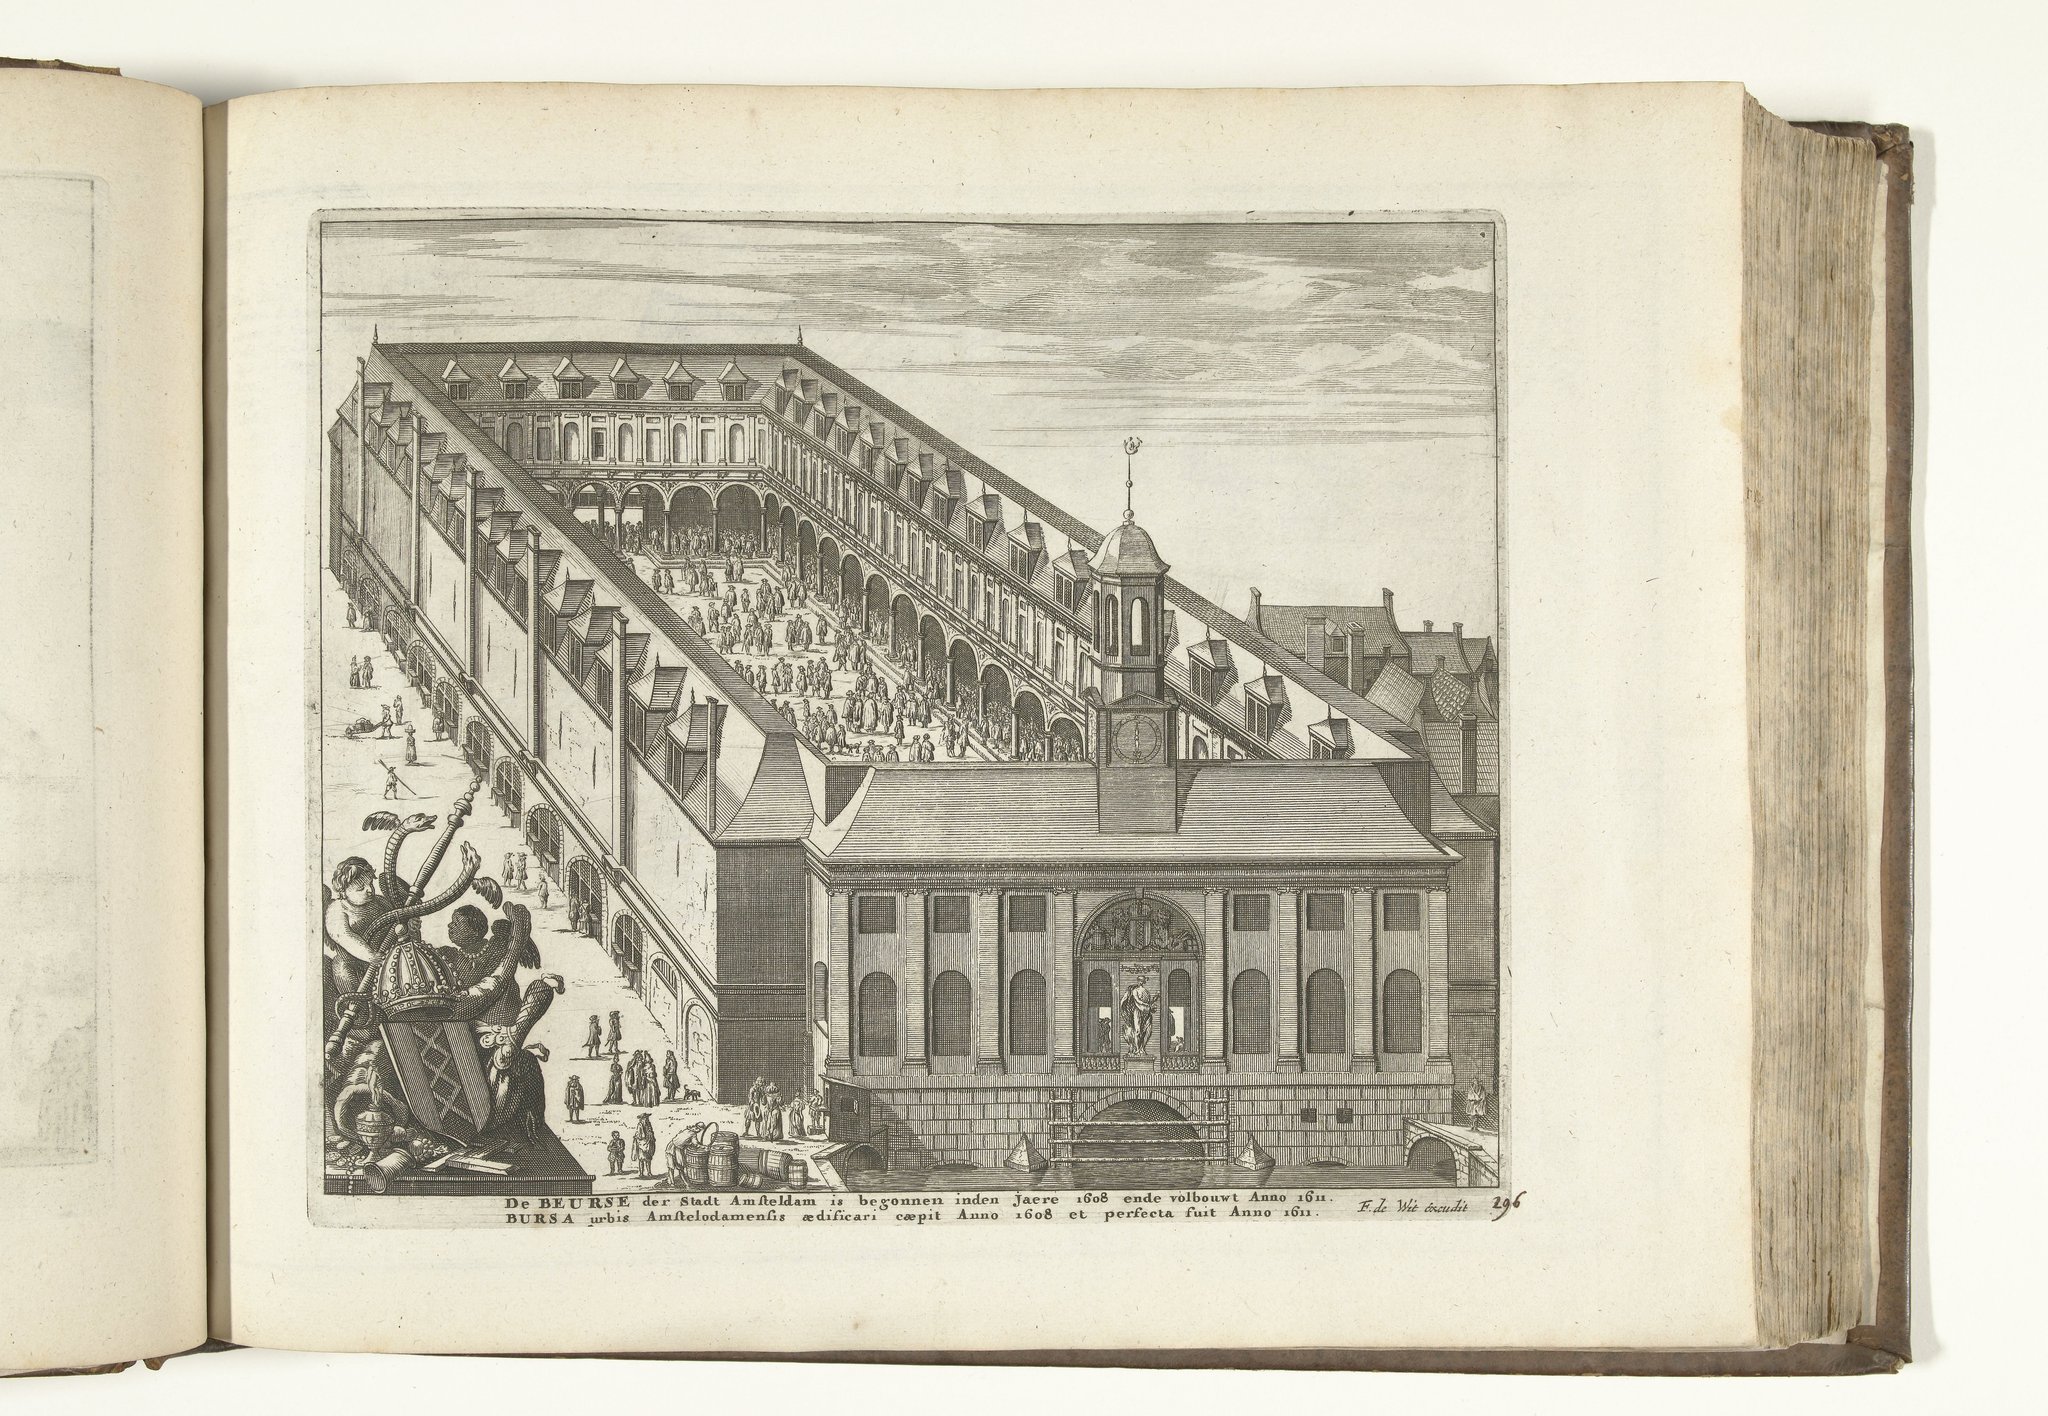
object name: print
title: De Beurse der Stadt Amsteldam (...) / Bursa urbis Amstelodamensis (...)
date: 1726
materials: paper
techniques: engraving, etching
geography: northern netherlands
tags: beurs van hendrik de keyser, spaanse successieoorlog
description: Gezicht op de beurs van Hendrik de Keyser te Amsterdam. Plaat nr. 296 in deel XIII van het prentwerk: Les Forces de l'Europe, Asie, Afrique et Amerique ... Comme aussi les Cartes des Côtes de France et d'Espagne uit 1726, dit tweede deel met 271 met de hand genummerde platen van vermaarde sterke steden en vestingen in het kader van de Spaanse Successieoorlog 1701-1713. Voor het merendeel zijn deze platen gekopieerd naar de anonieme Franse platen van vermaarde sterke steden en vestingen: in Les forces de l'Europe en in: Le theatre de la guerre, dans les Pays-Bas, beide oorspronkelijk uitgegeven door Nicolas de Fer te Parijs (1693-1697) in het kader van de Negenjarige Oorlog. Titel in het Nederlands en Latijn.